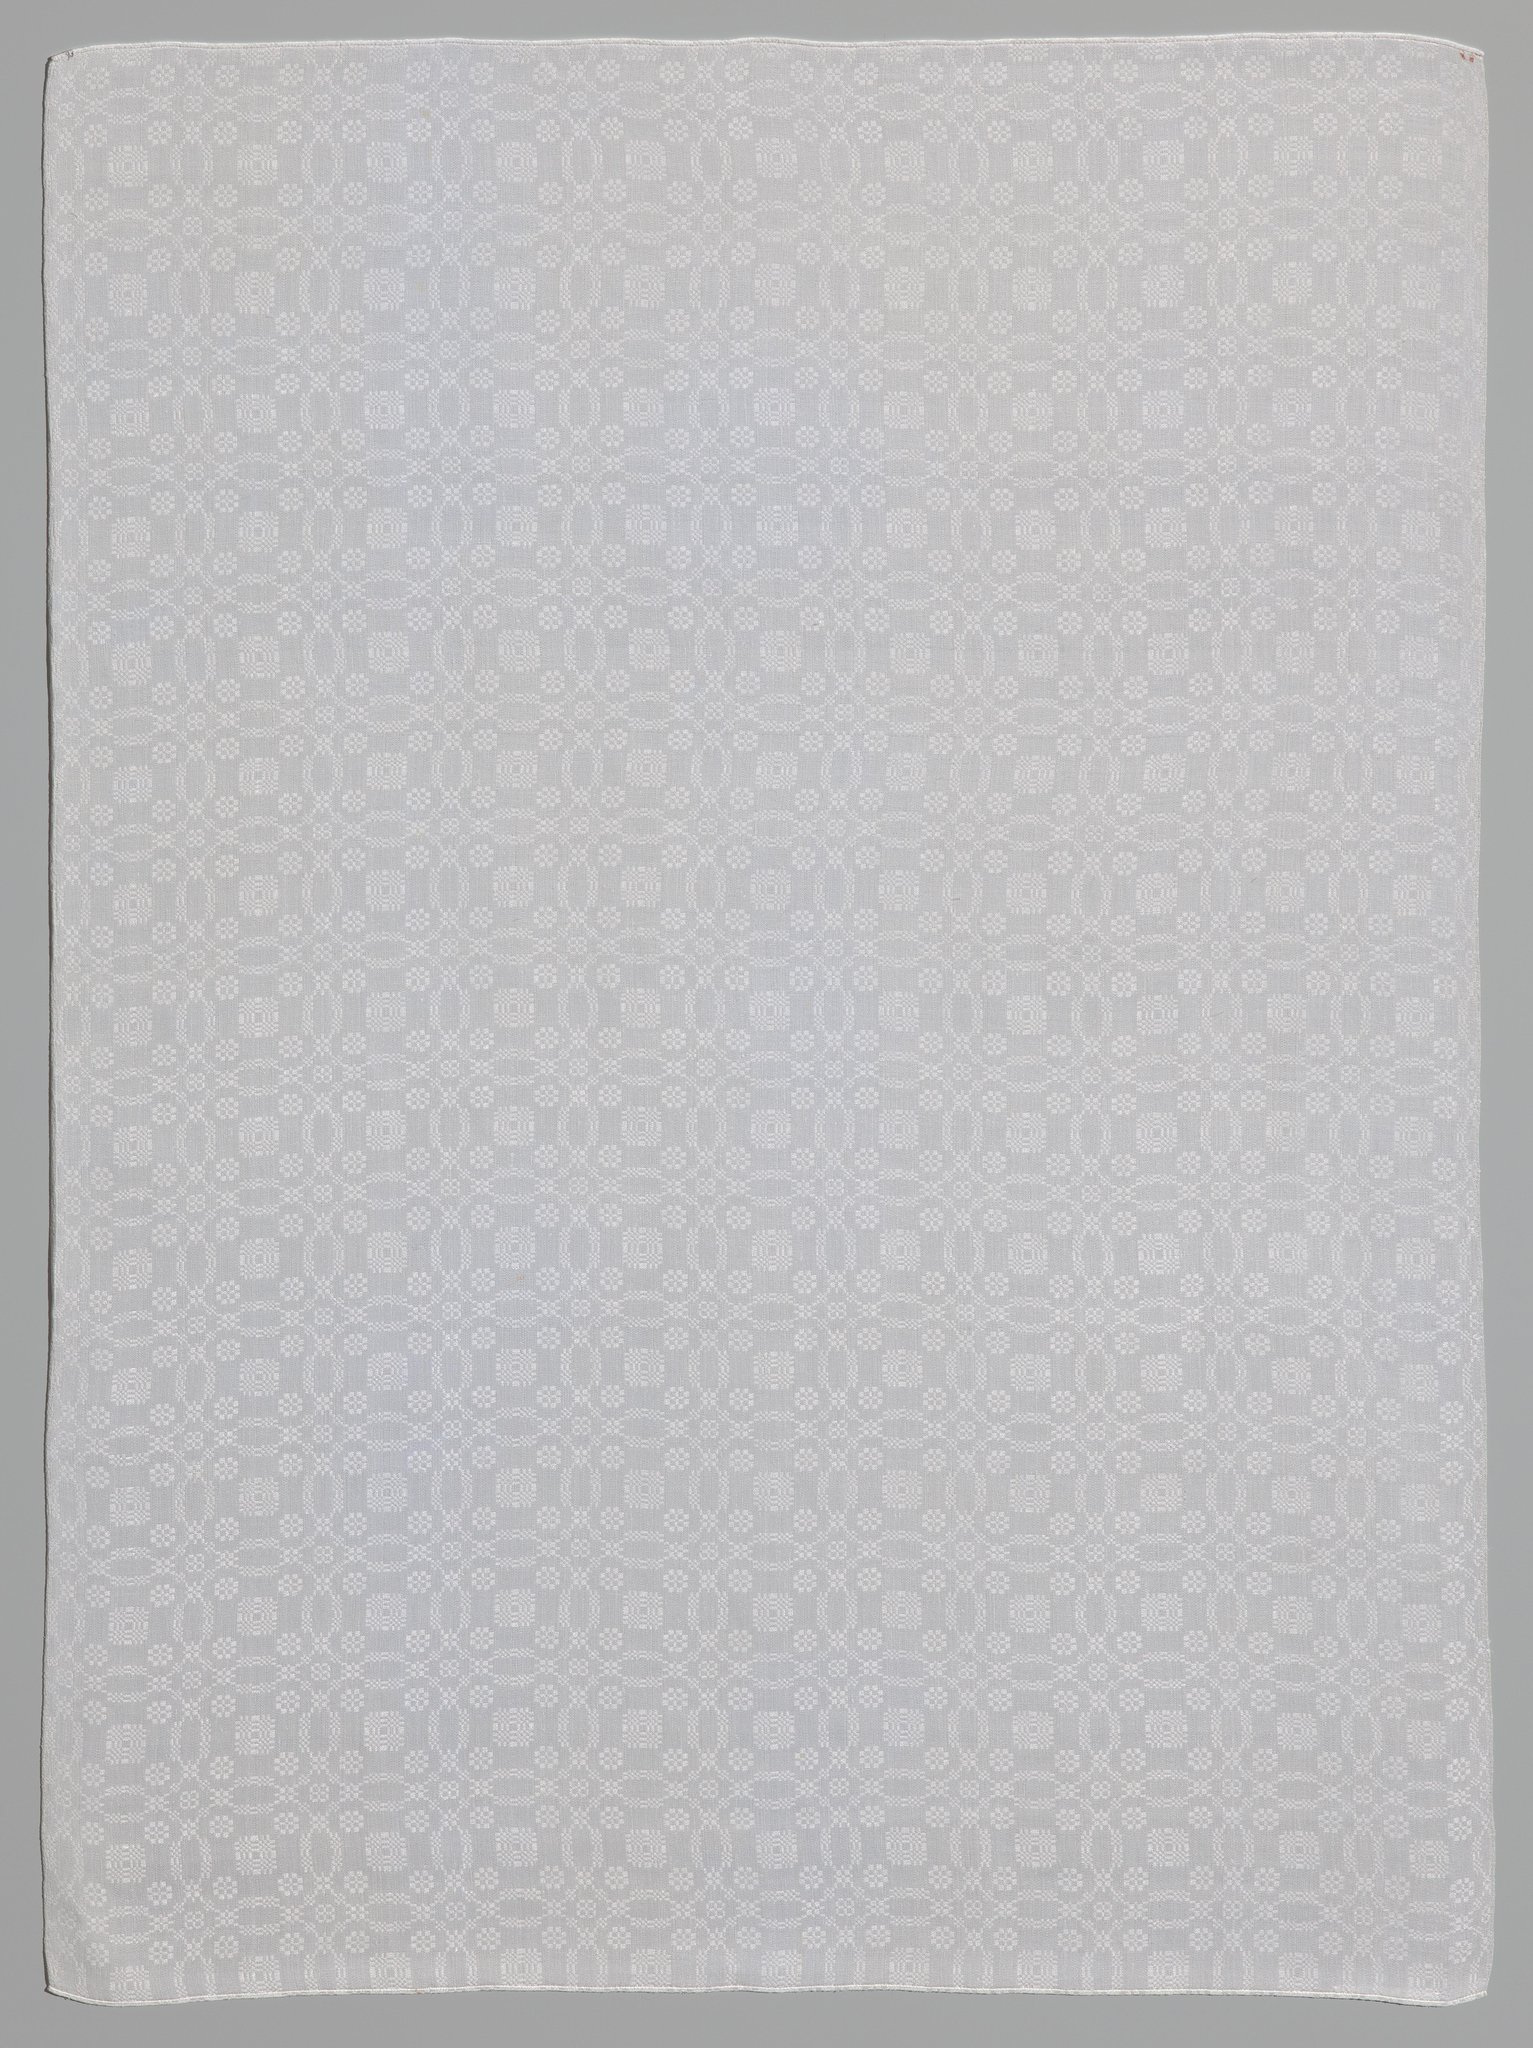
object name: napkin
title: Servet van pellendamast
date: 1675-1700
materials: linen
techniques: weave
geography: netherlands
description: Servet van pellendamast. Het servet is gemerkt: KS. Bij het servet hoort een servet met invnr. BK-1980-112-A.